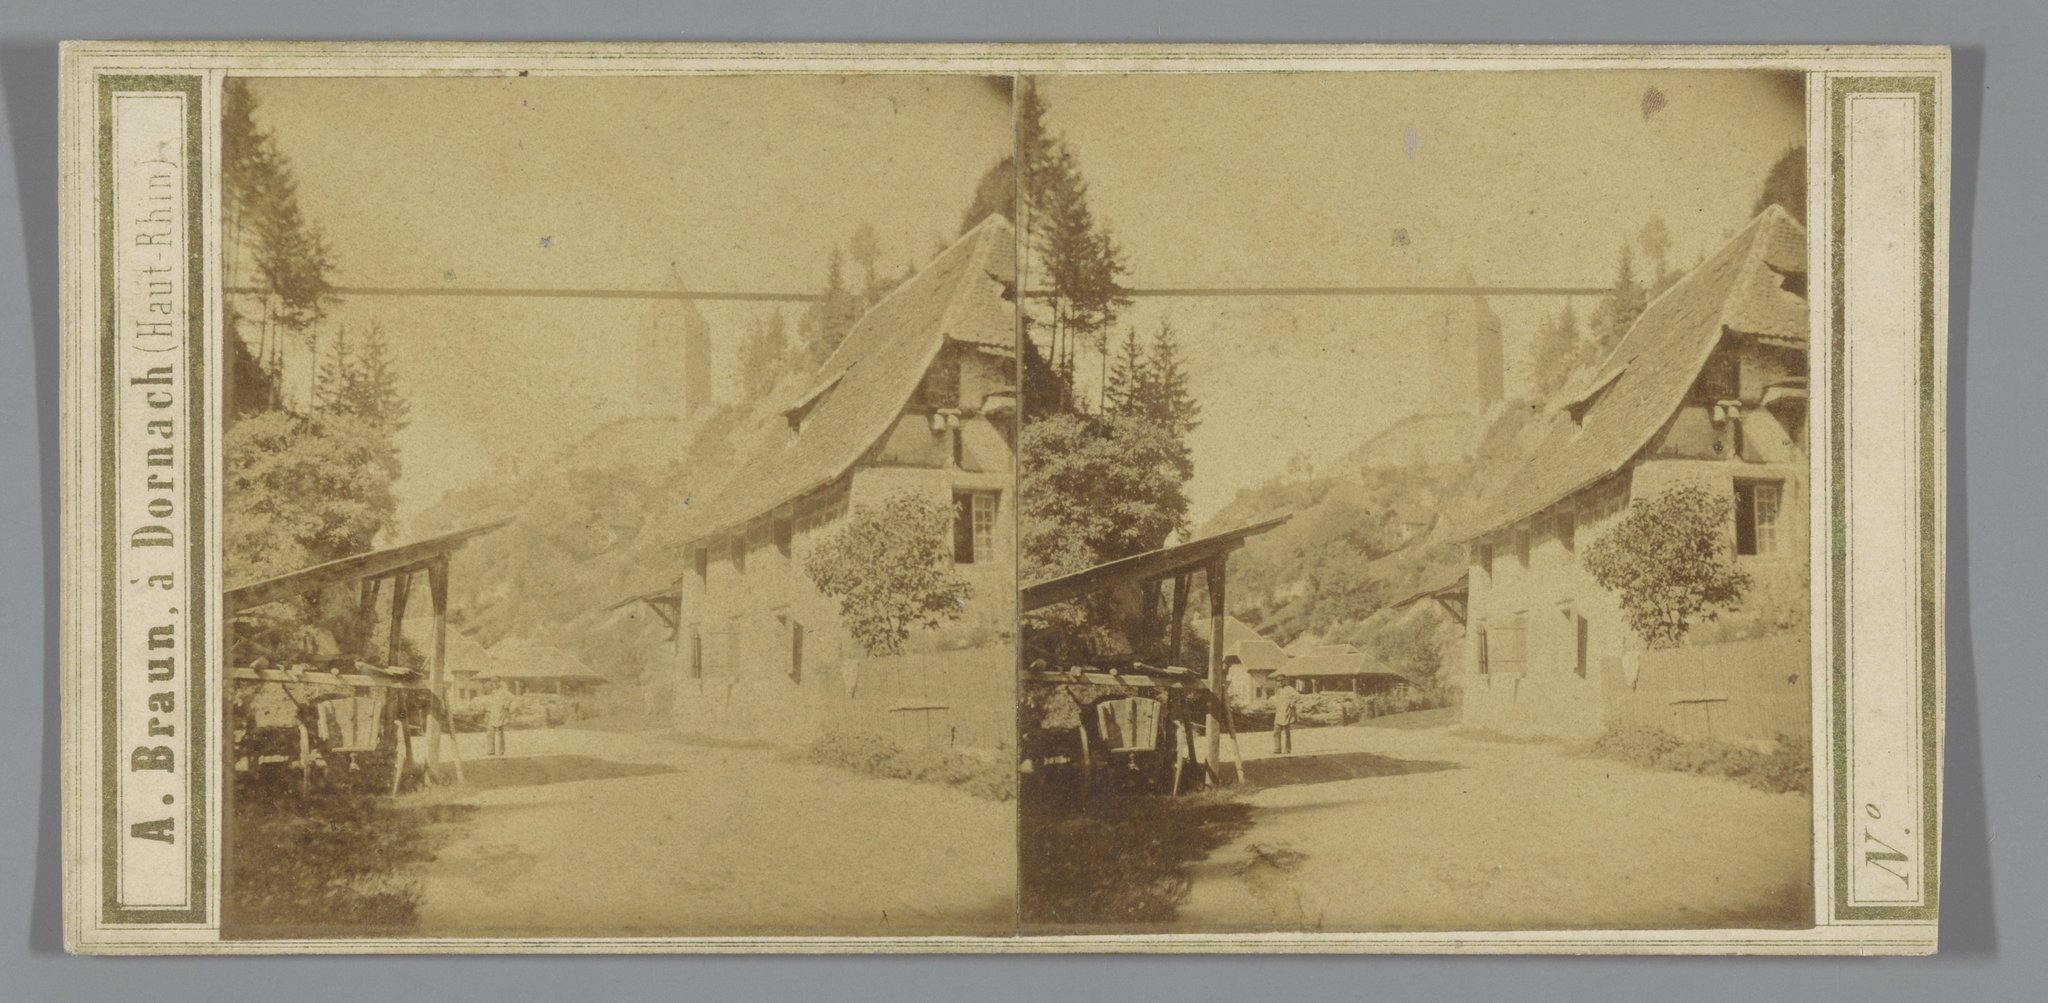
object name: stereograph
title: Vallée du Gotteron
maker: Anonymous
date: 1860-1866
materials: cardboard, paper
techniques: albumen print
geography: dornach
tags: street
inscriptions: number: ‘570.’